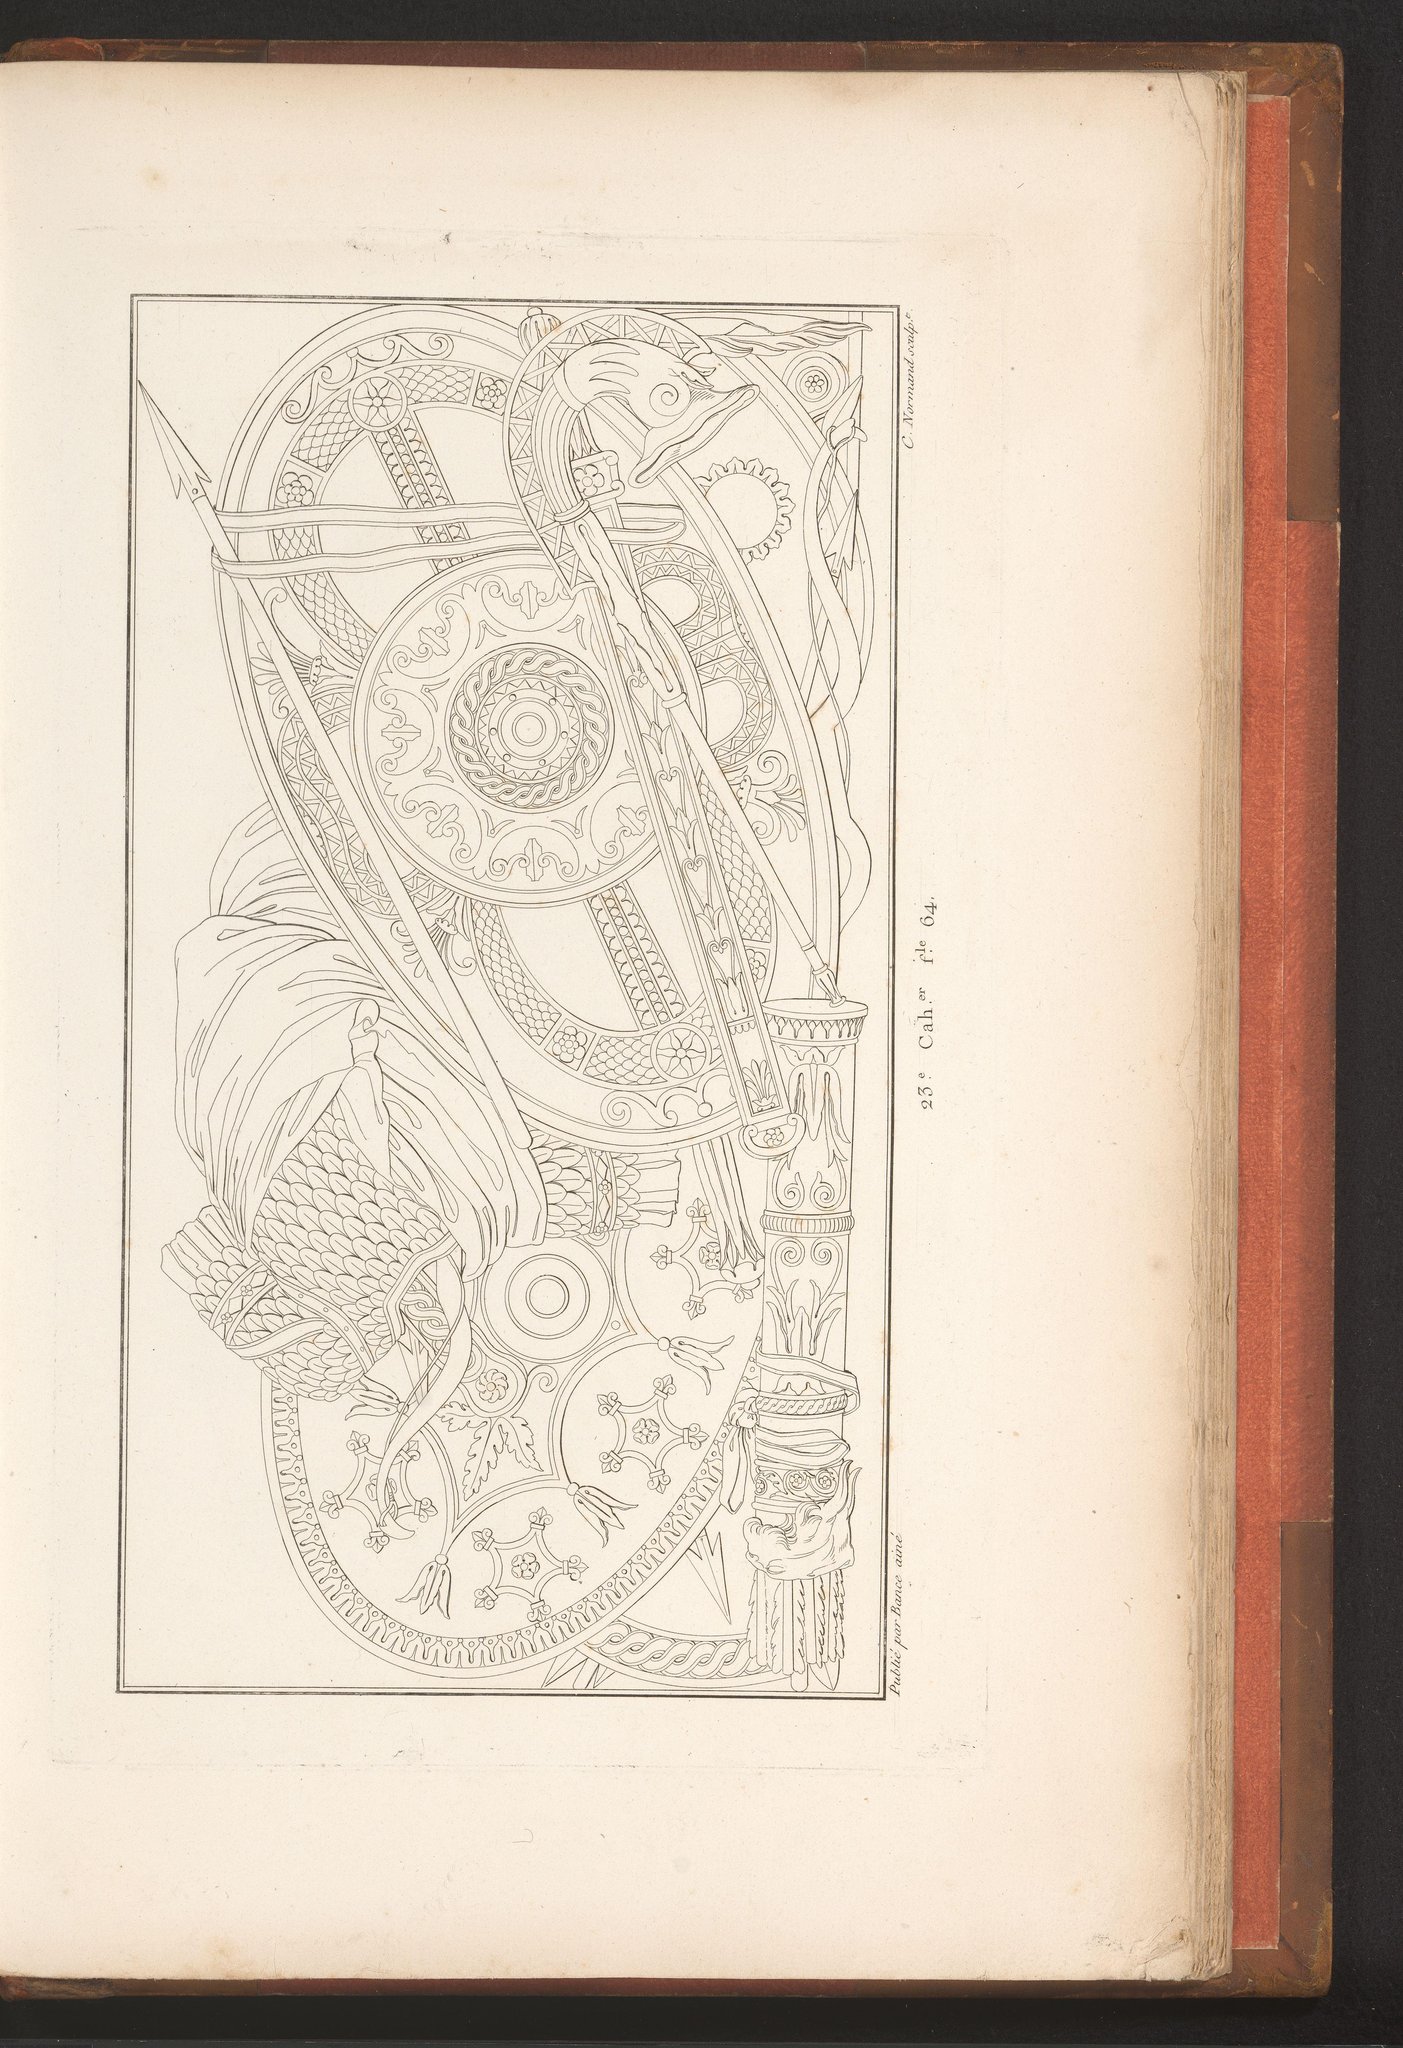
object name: ornament print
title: Wapentrofee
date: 1820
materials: paper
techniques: etching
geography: paris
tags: ornaments ~ art, 'tropaion', i.e. decorative ornament ~ weapons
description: Wapentrofee, ornament met wapens en wapenrusting, overgenomen van de Zuil van Trajanus. Onderdeel (23e. Cah.er f.le 64) van het prentalbum met twee series van in totaal 138 ornamentprenten door Beauvallet en Normand, 'Fragmens d'Ornemens dans le Style Antique'.